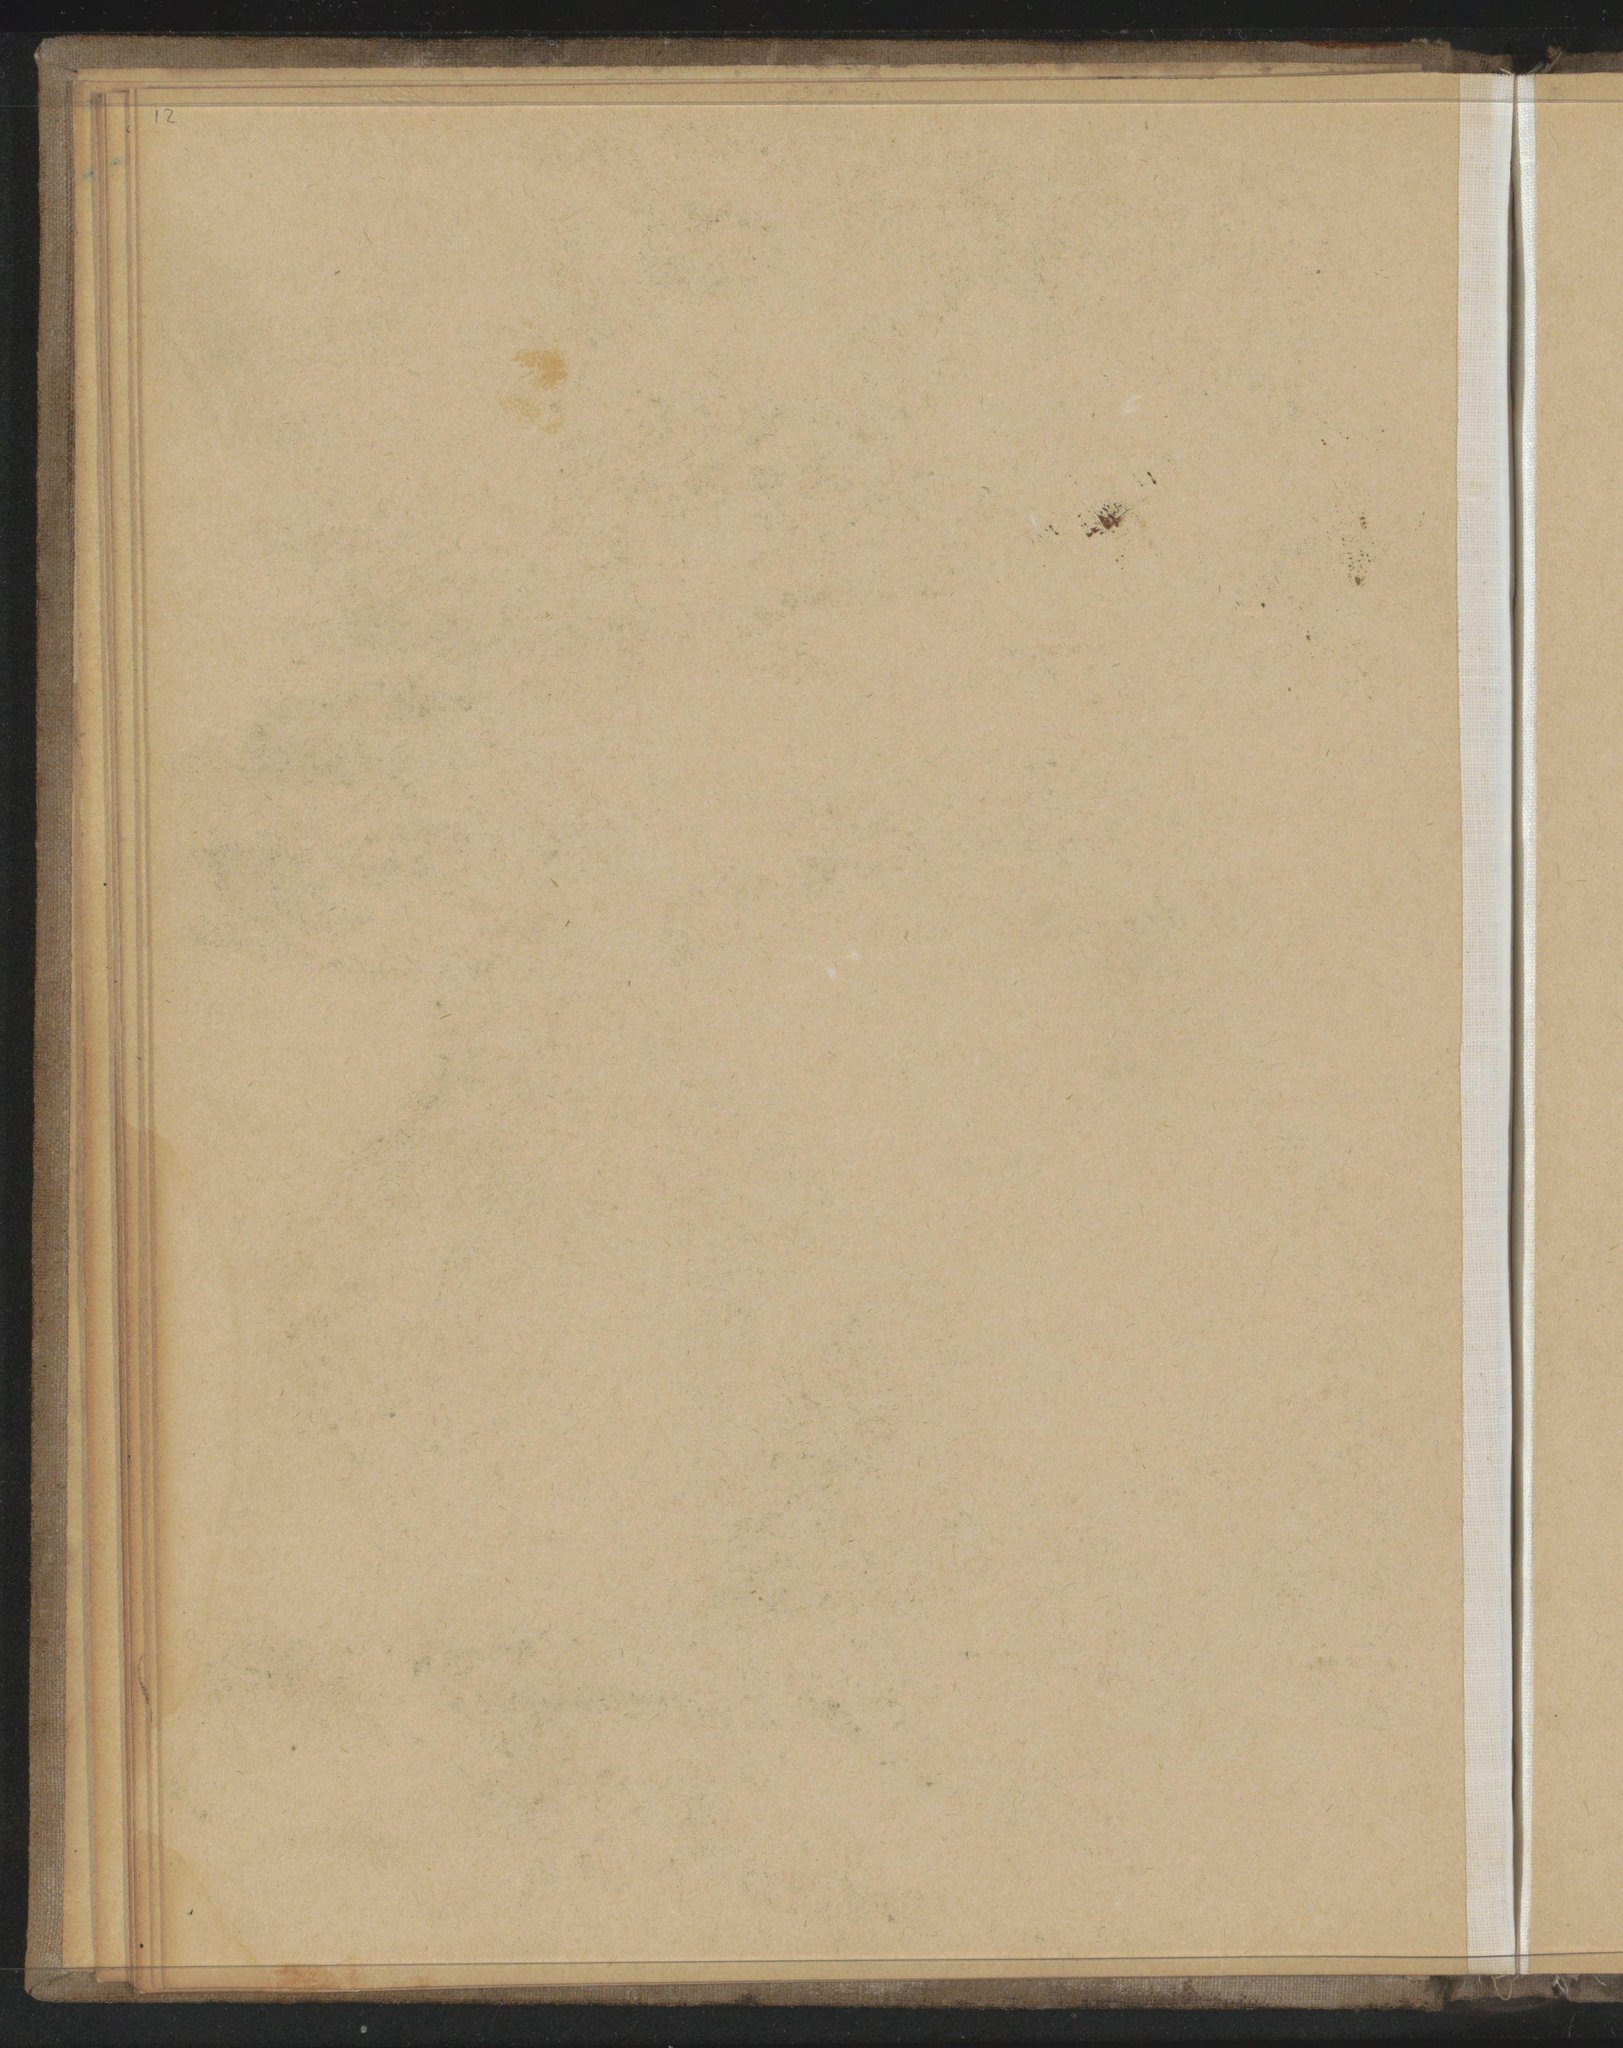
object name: sketchbook leaf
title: Abklatsch van de krijttekening op pagina 13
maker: willem witsen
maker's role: draughtsman, painter, print maker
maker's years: 1860-1923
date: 1892-1897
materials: paper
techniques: printmaking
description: Pagina 12 uit een schetsboek met 24 bladen.